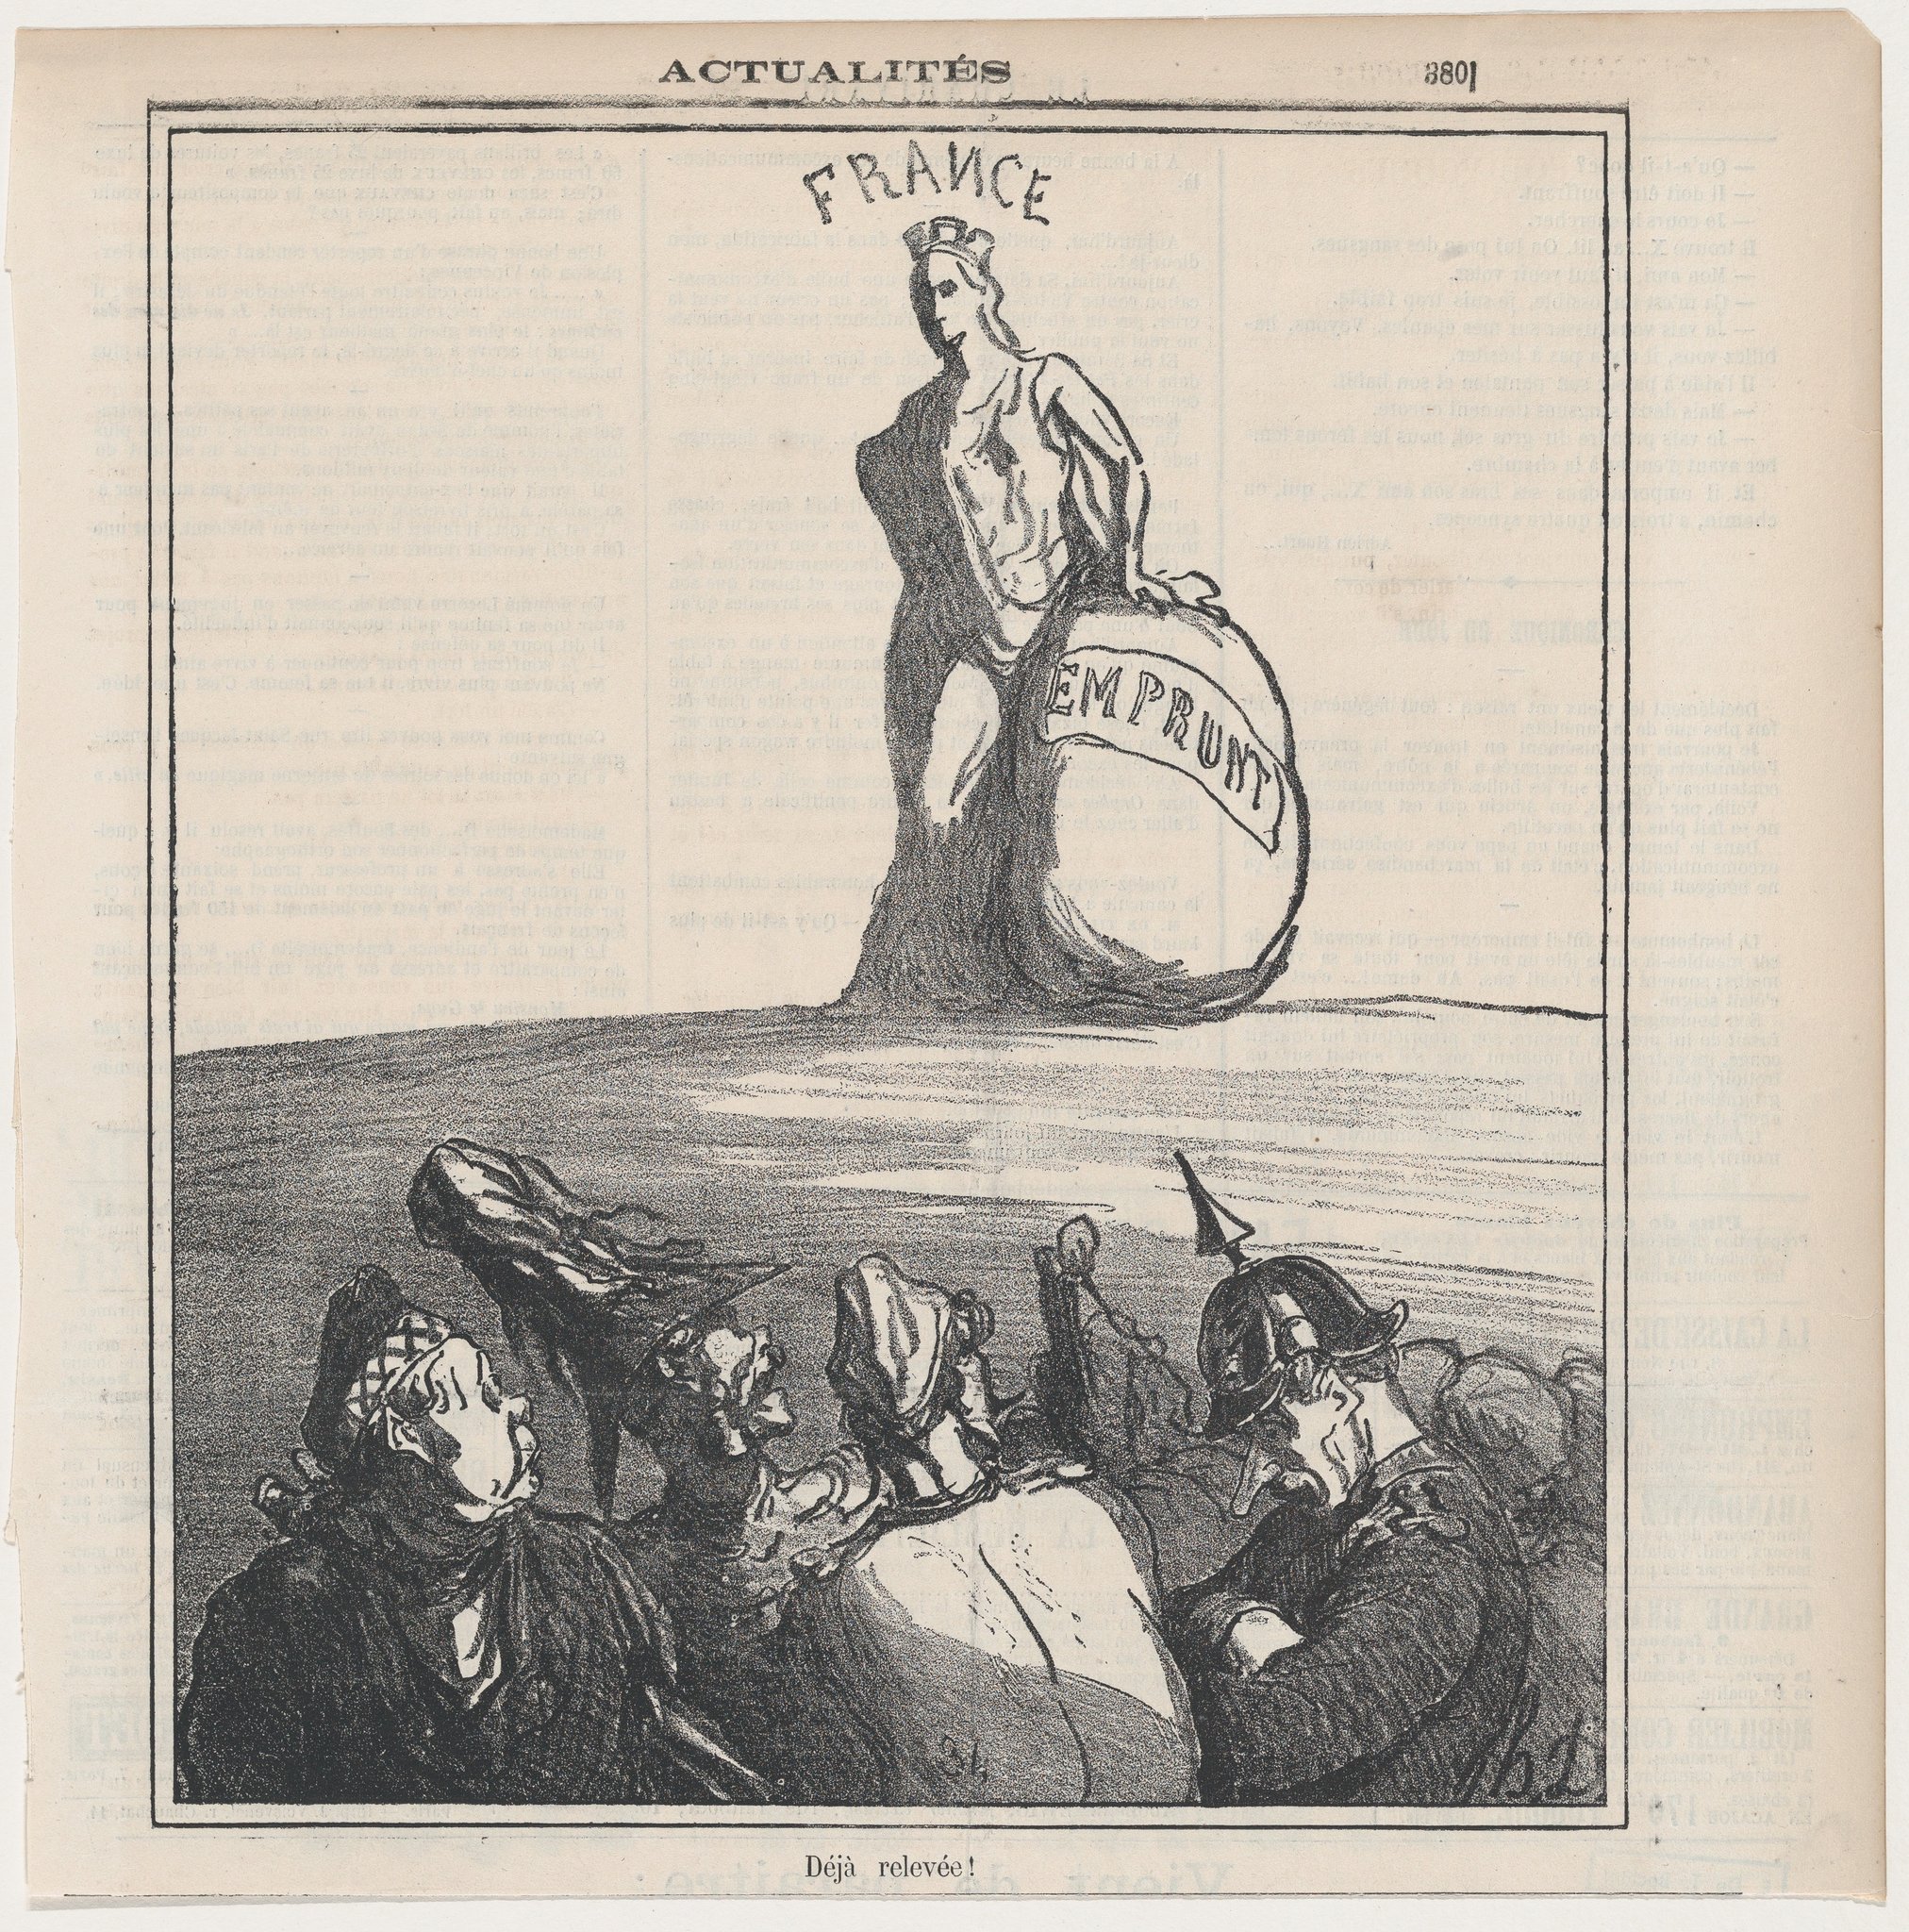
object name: print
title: Already on her feet again!, from "News of the day"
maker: honoré daumier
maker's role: artist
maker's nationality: french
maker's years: 1808-1879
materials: paper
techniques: lithograph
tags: satire,men,women